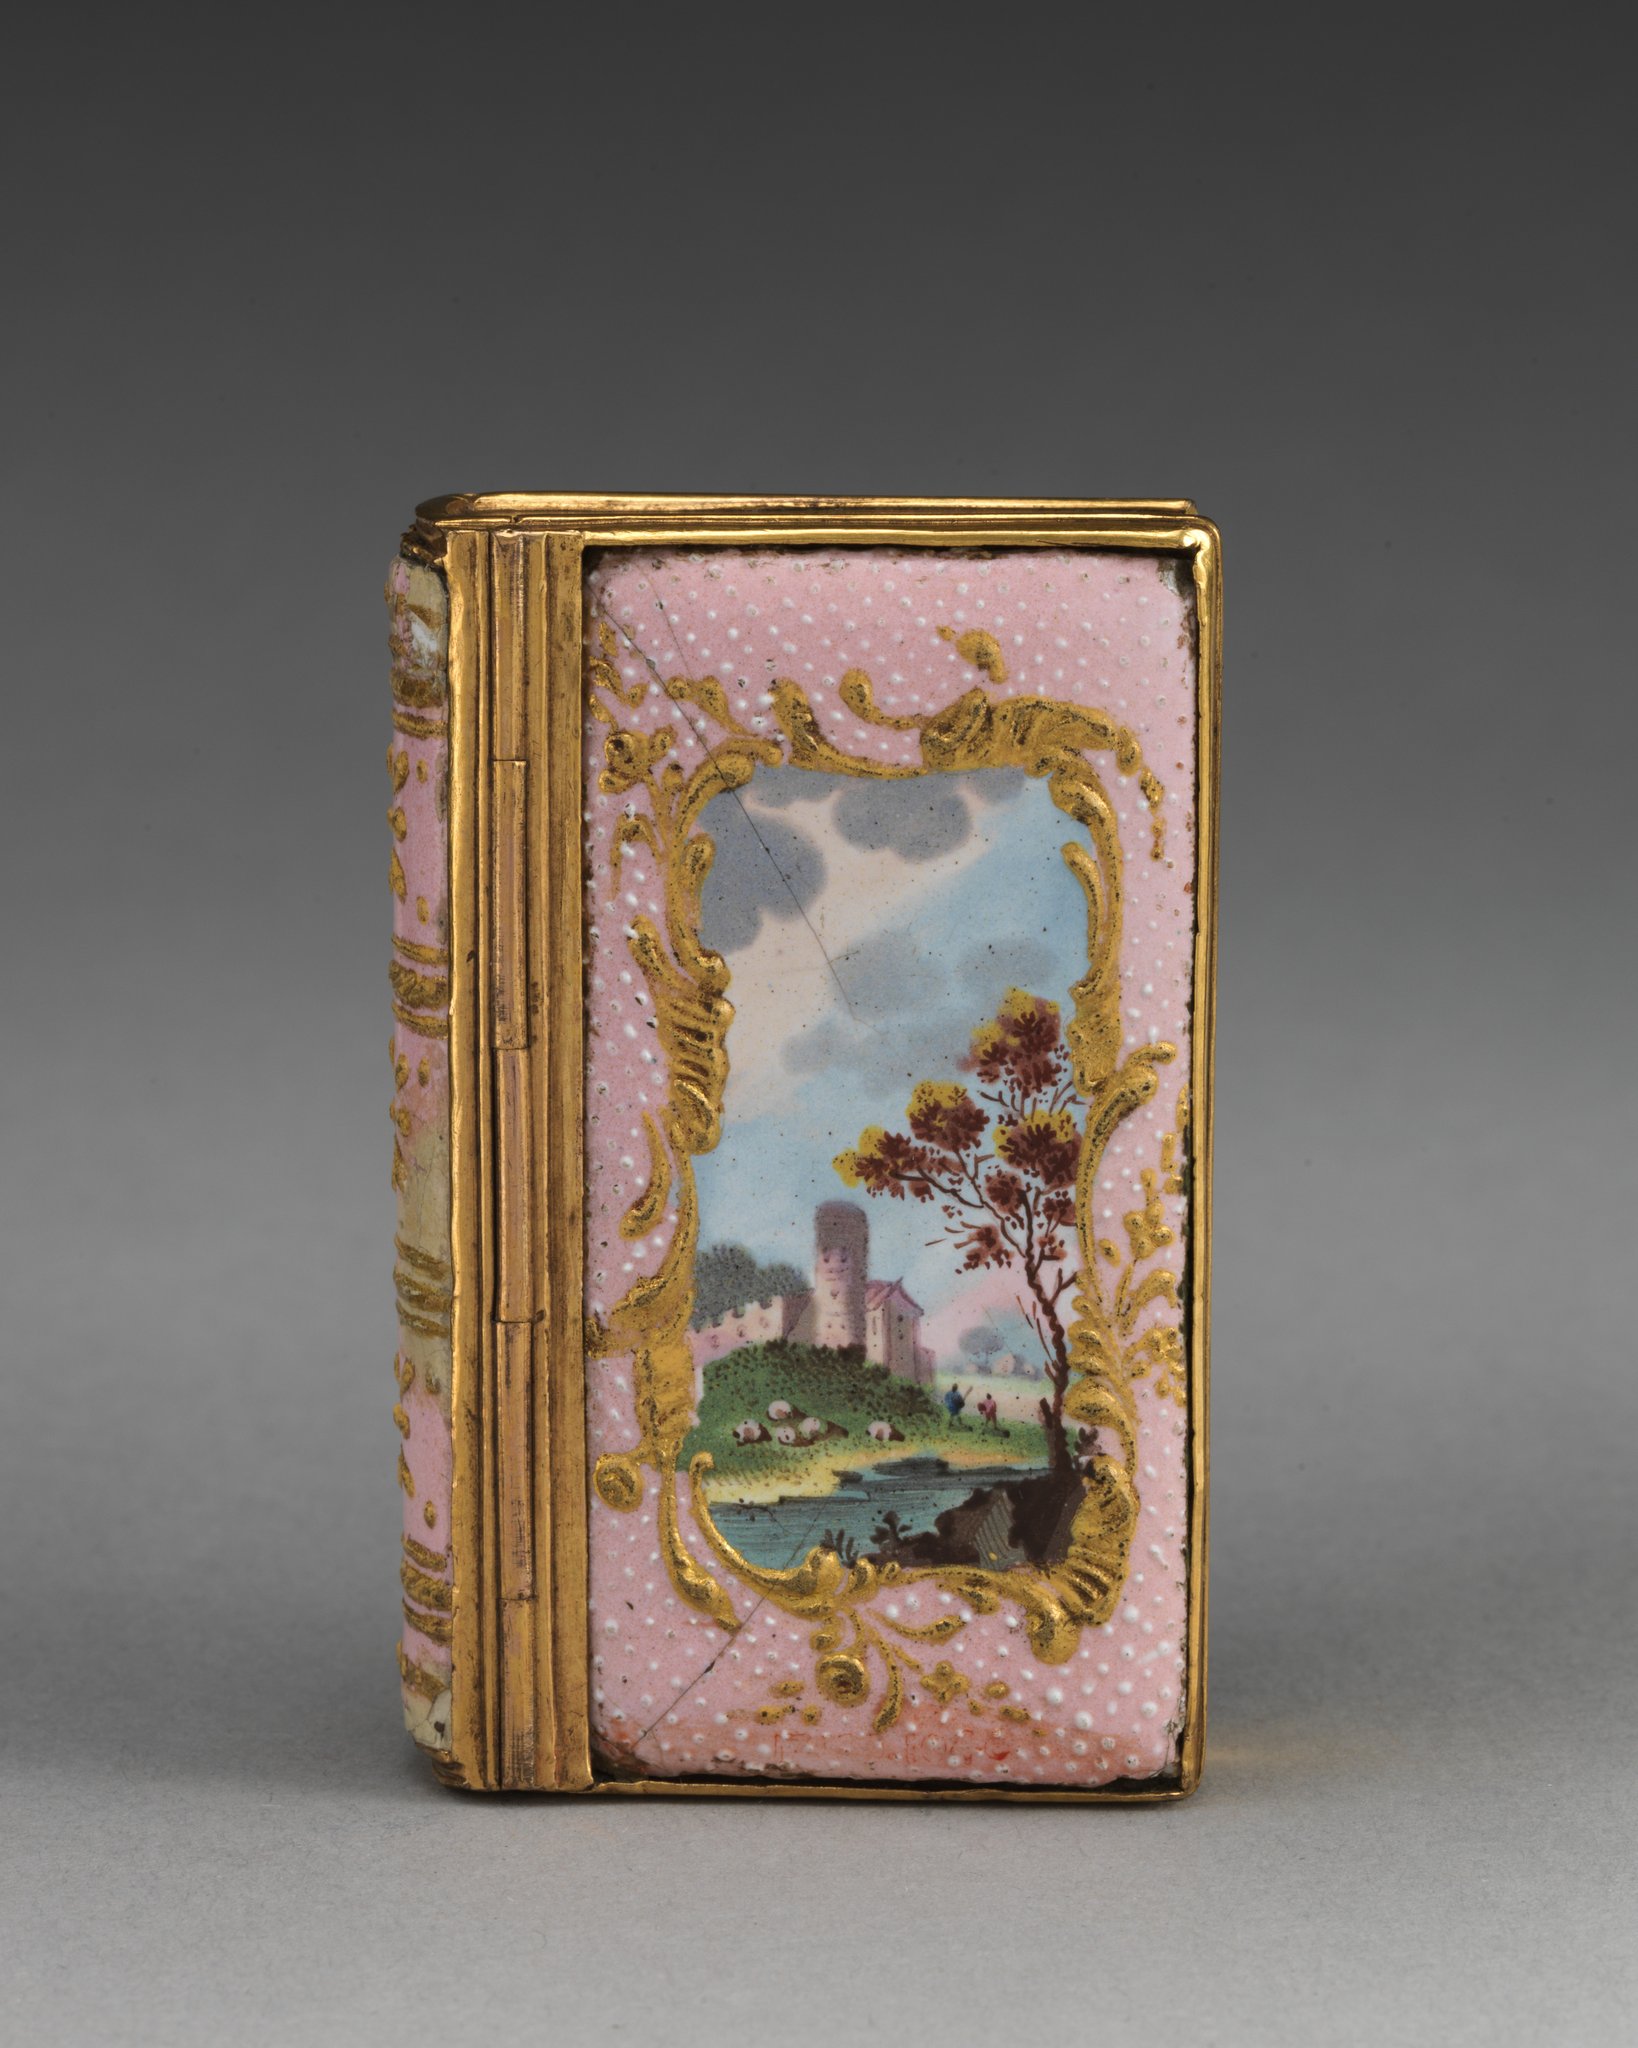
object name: snuffbox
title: Book-shaped snuffbox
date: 1765-1770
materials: copper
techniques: enamel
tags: buildings,trees